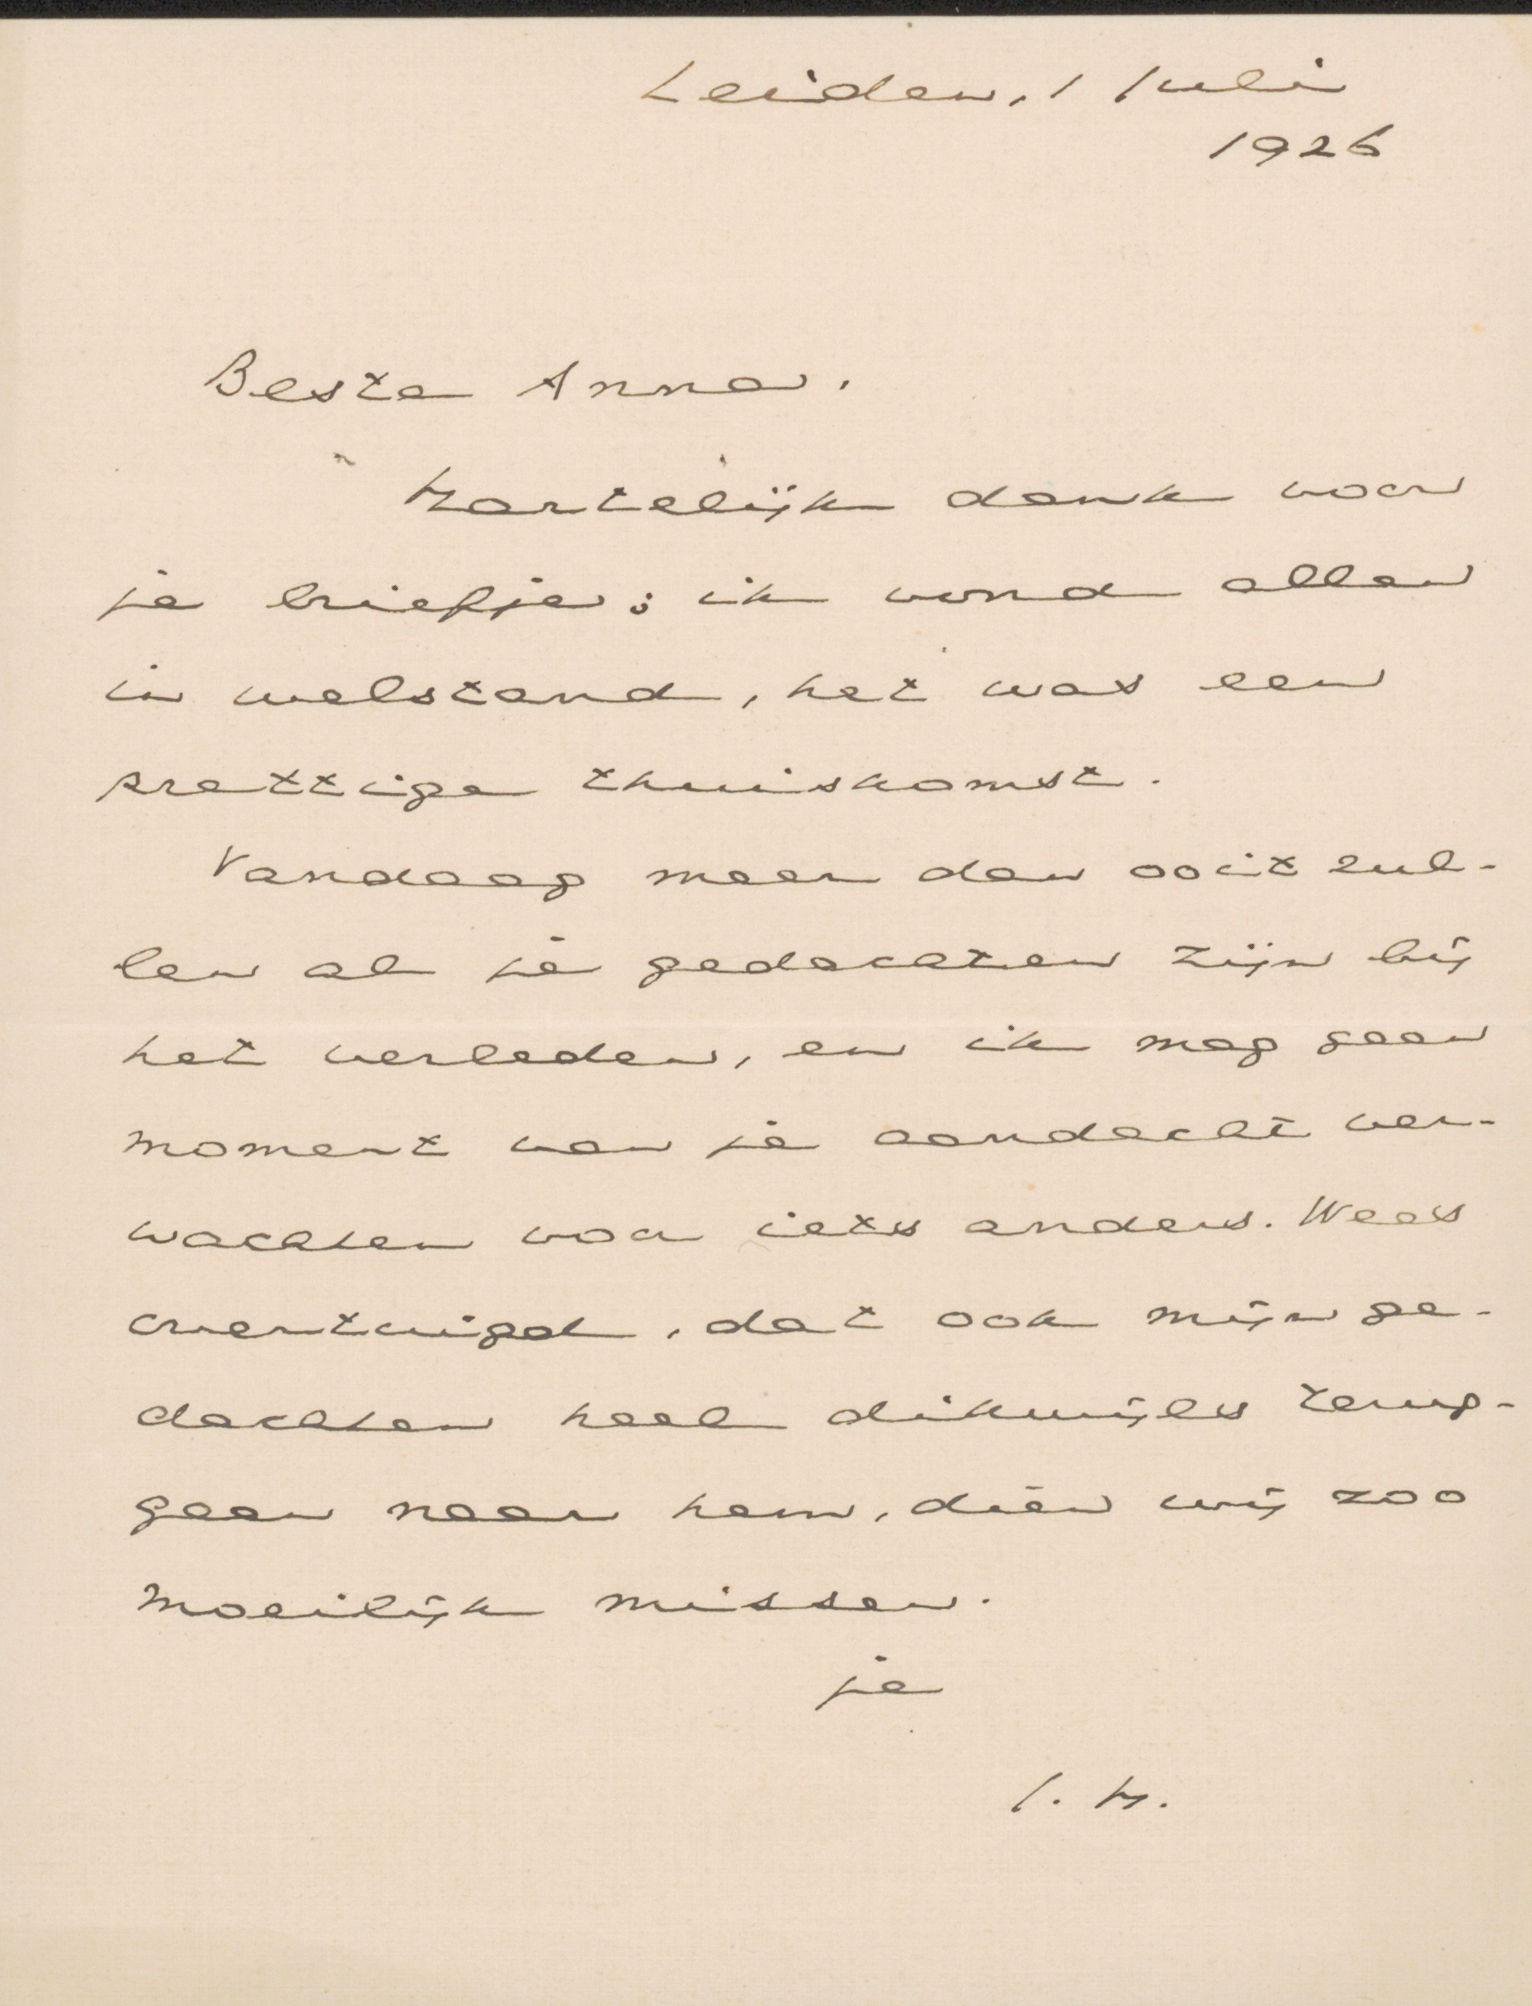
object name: letter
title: Brief aan Anna Dorothea Dirks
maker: johan huizinga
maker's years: 1872-1945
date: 1926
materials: ink, paper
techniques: pen, writing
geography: leiden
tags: dordrecht, amsterdam, painter, print maker, draughtsman, designer, jan veth, artist, anna dorothea dirks, passions, emotions, affections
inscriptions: collector's mark: ‘RPK’